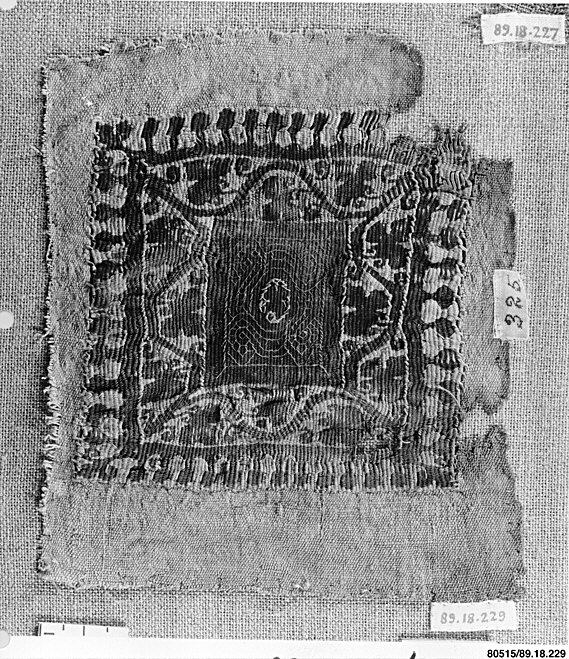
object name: textile fragment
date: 201-400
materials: linen, wool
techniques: weave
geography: egypt